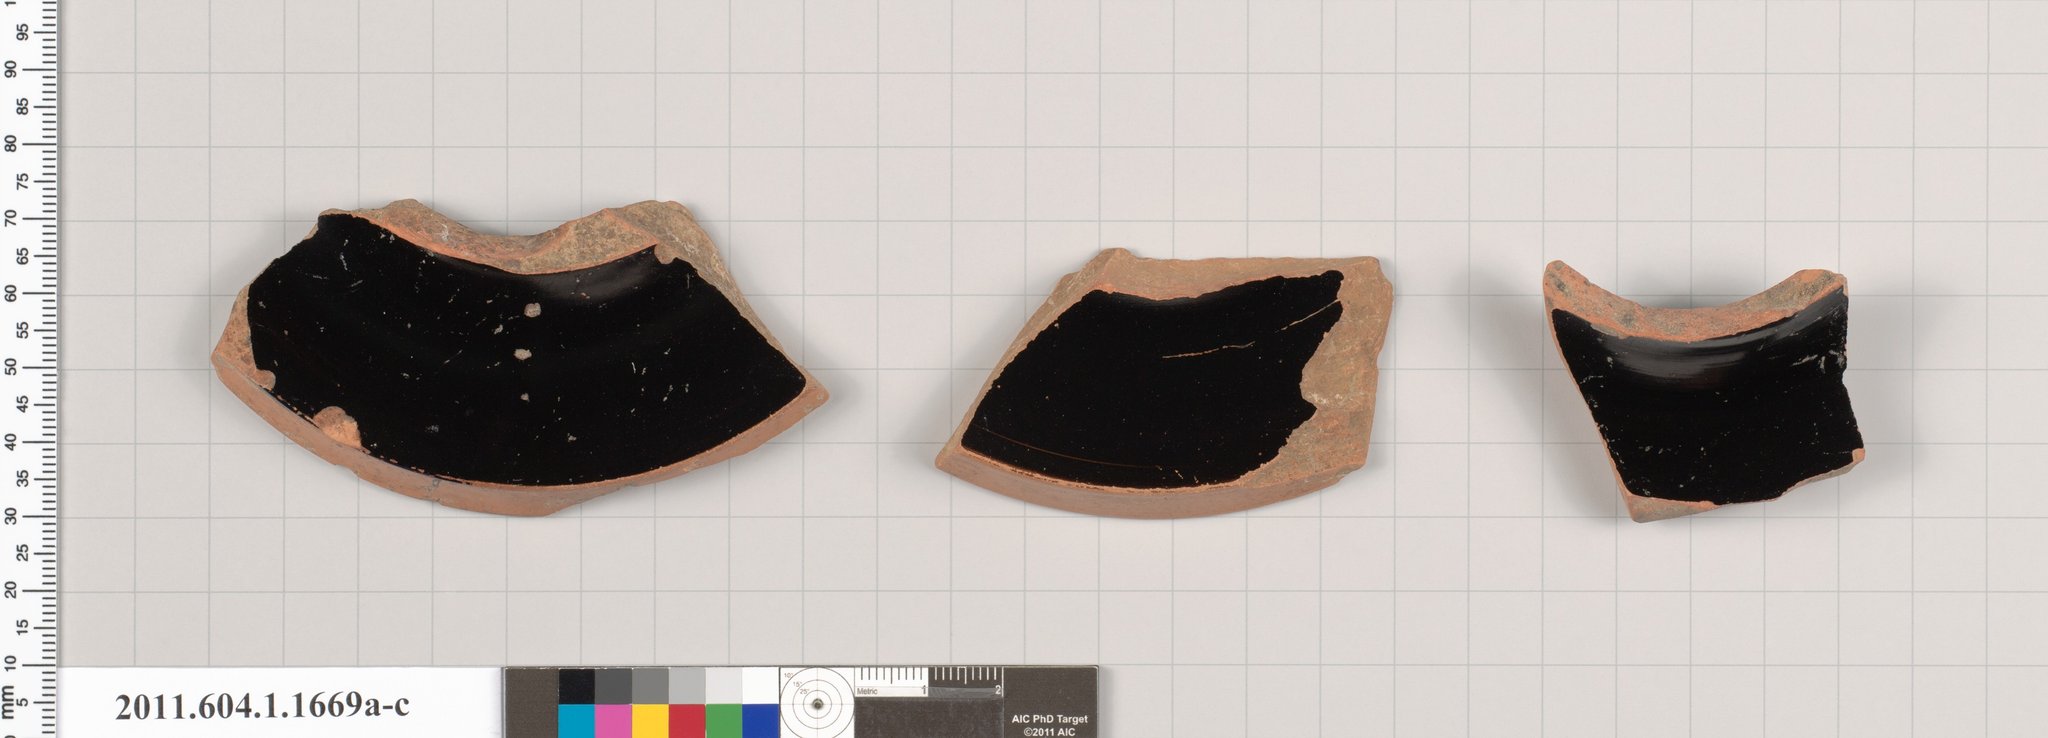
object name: kylix fragment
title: Terracotta fragments of kylikes (drinking cups)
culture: greek, attic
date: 534-468 BCE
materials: terracotta